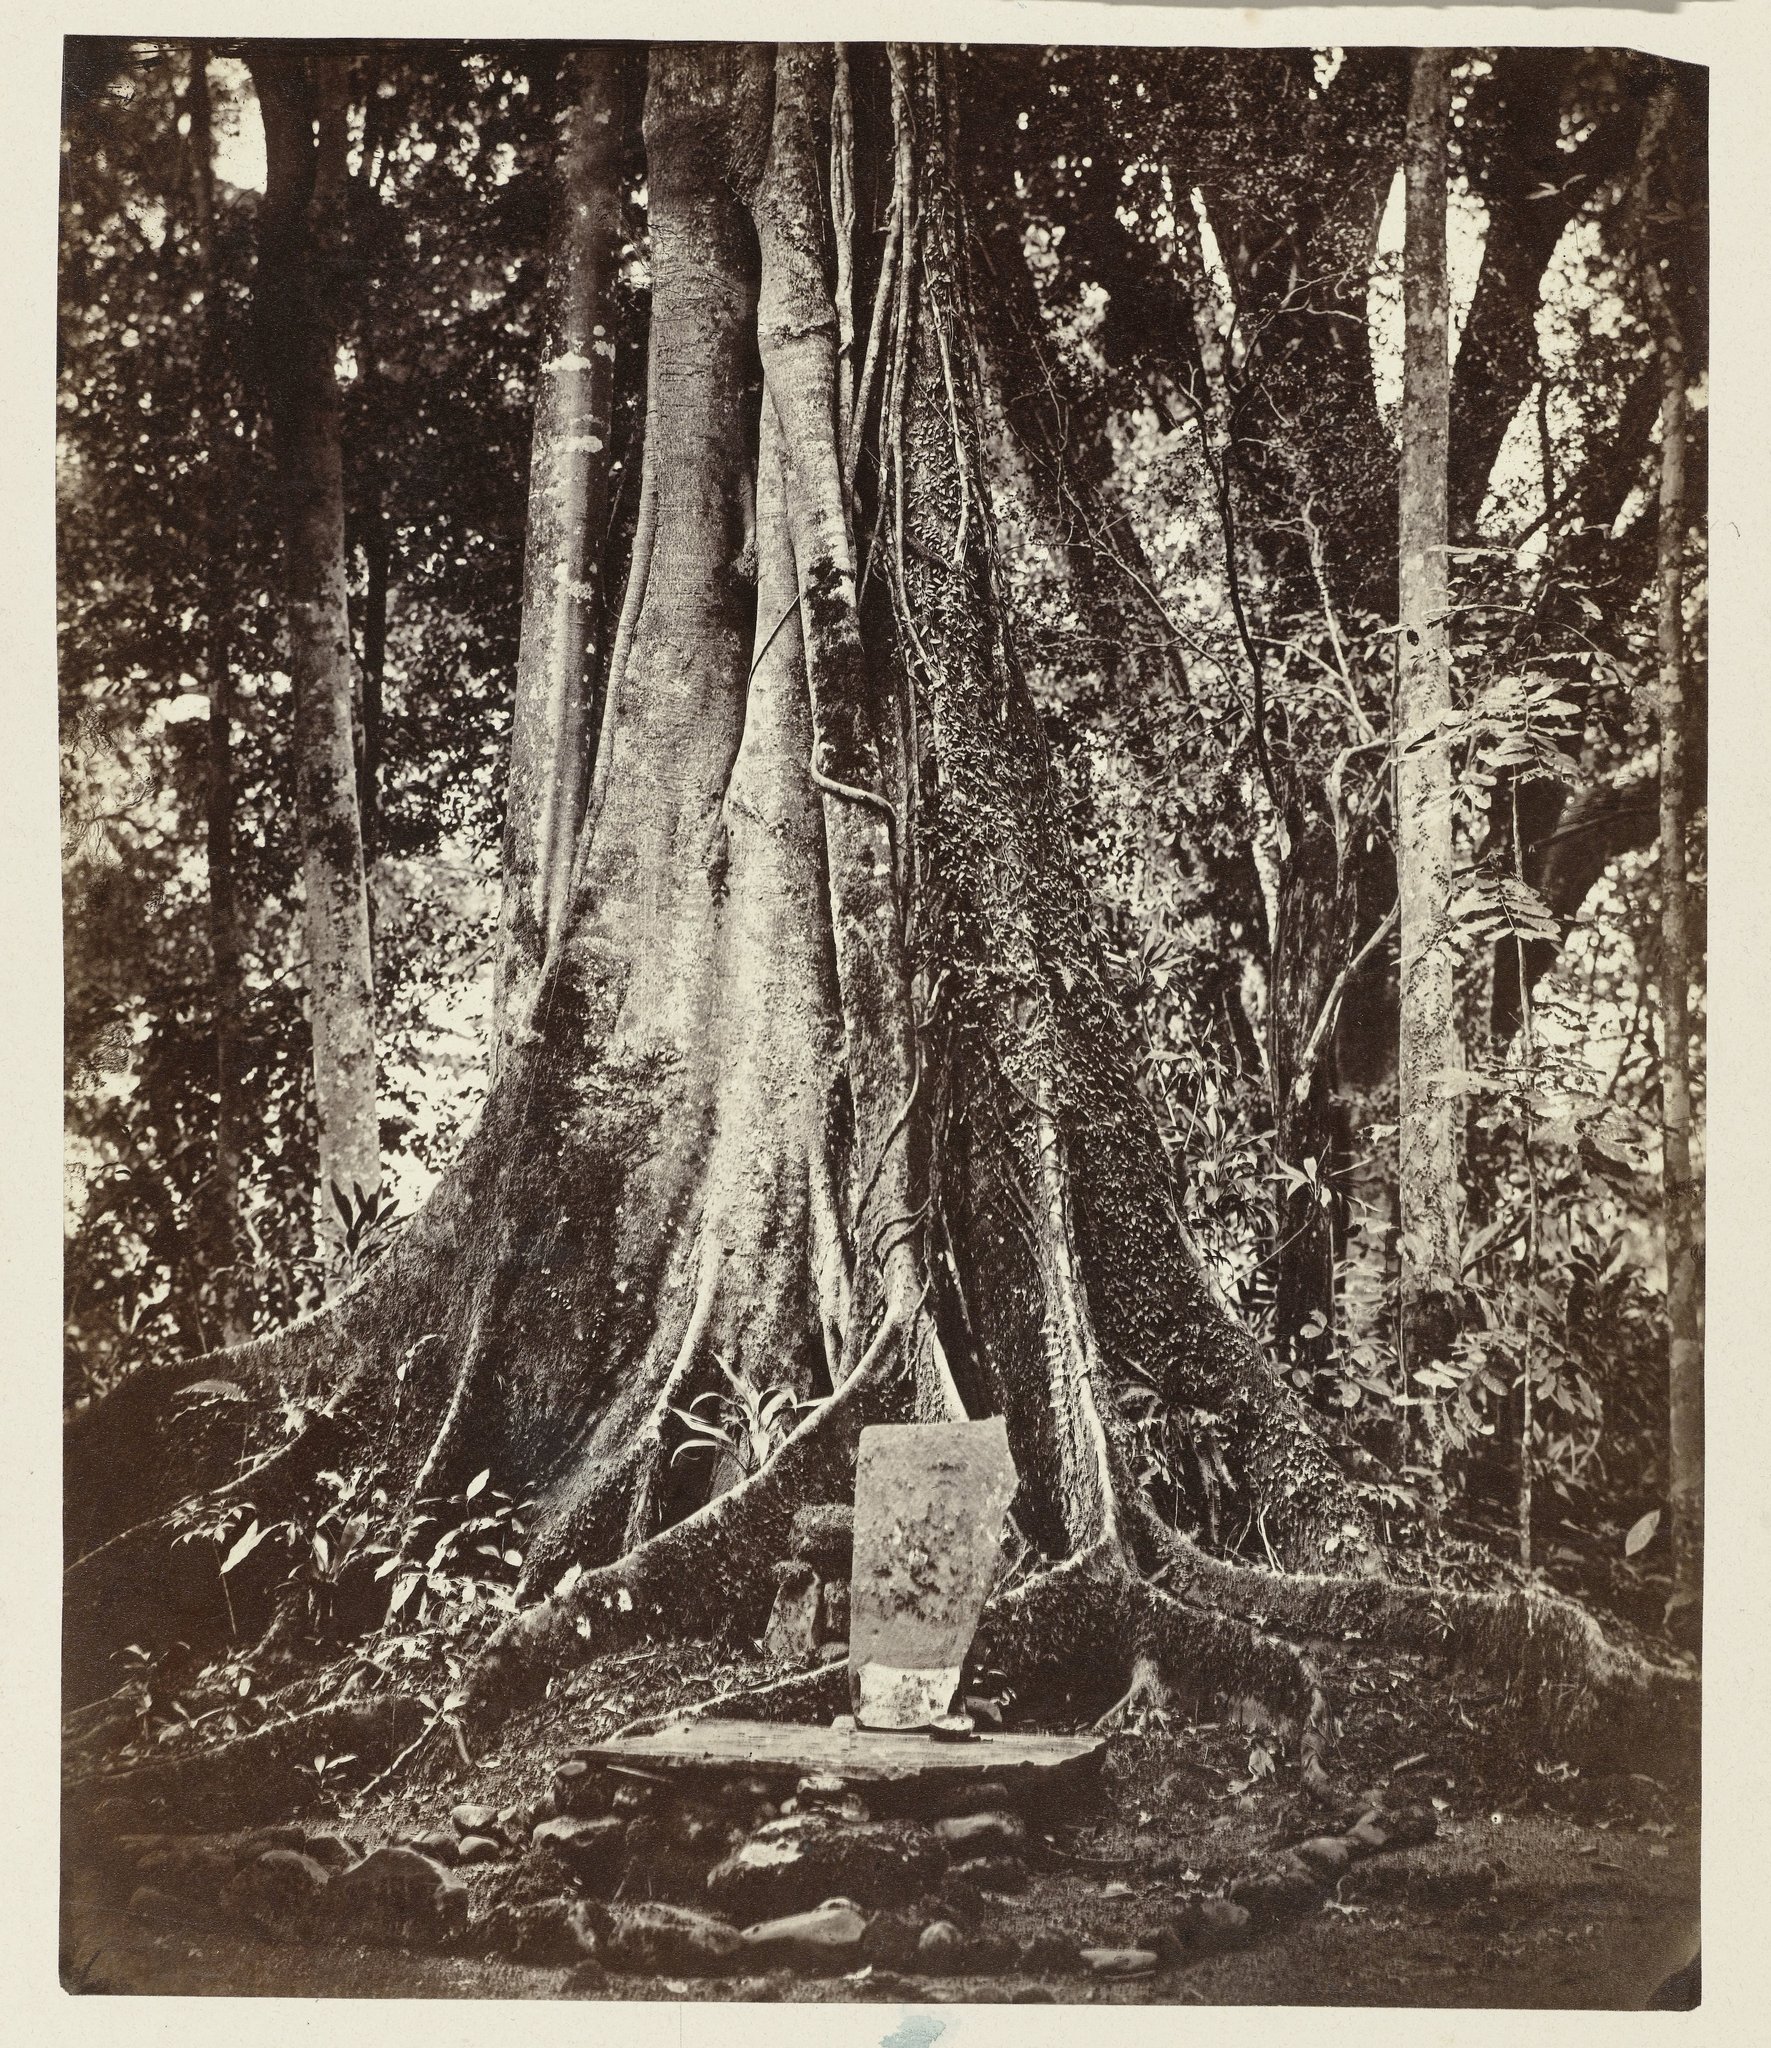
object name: photograph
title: Sacraficial place with ancestor images, Kawali, Ciamis district West Java province, 14th - 16th century.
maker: isidore kinsbergen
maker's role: fotograaf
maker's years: 1821-1905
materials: cardboard, paper, photographic support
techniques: albumen print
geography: java